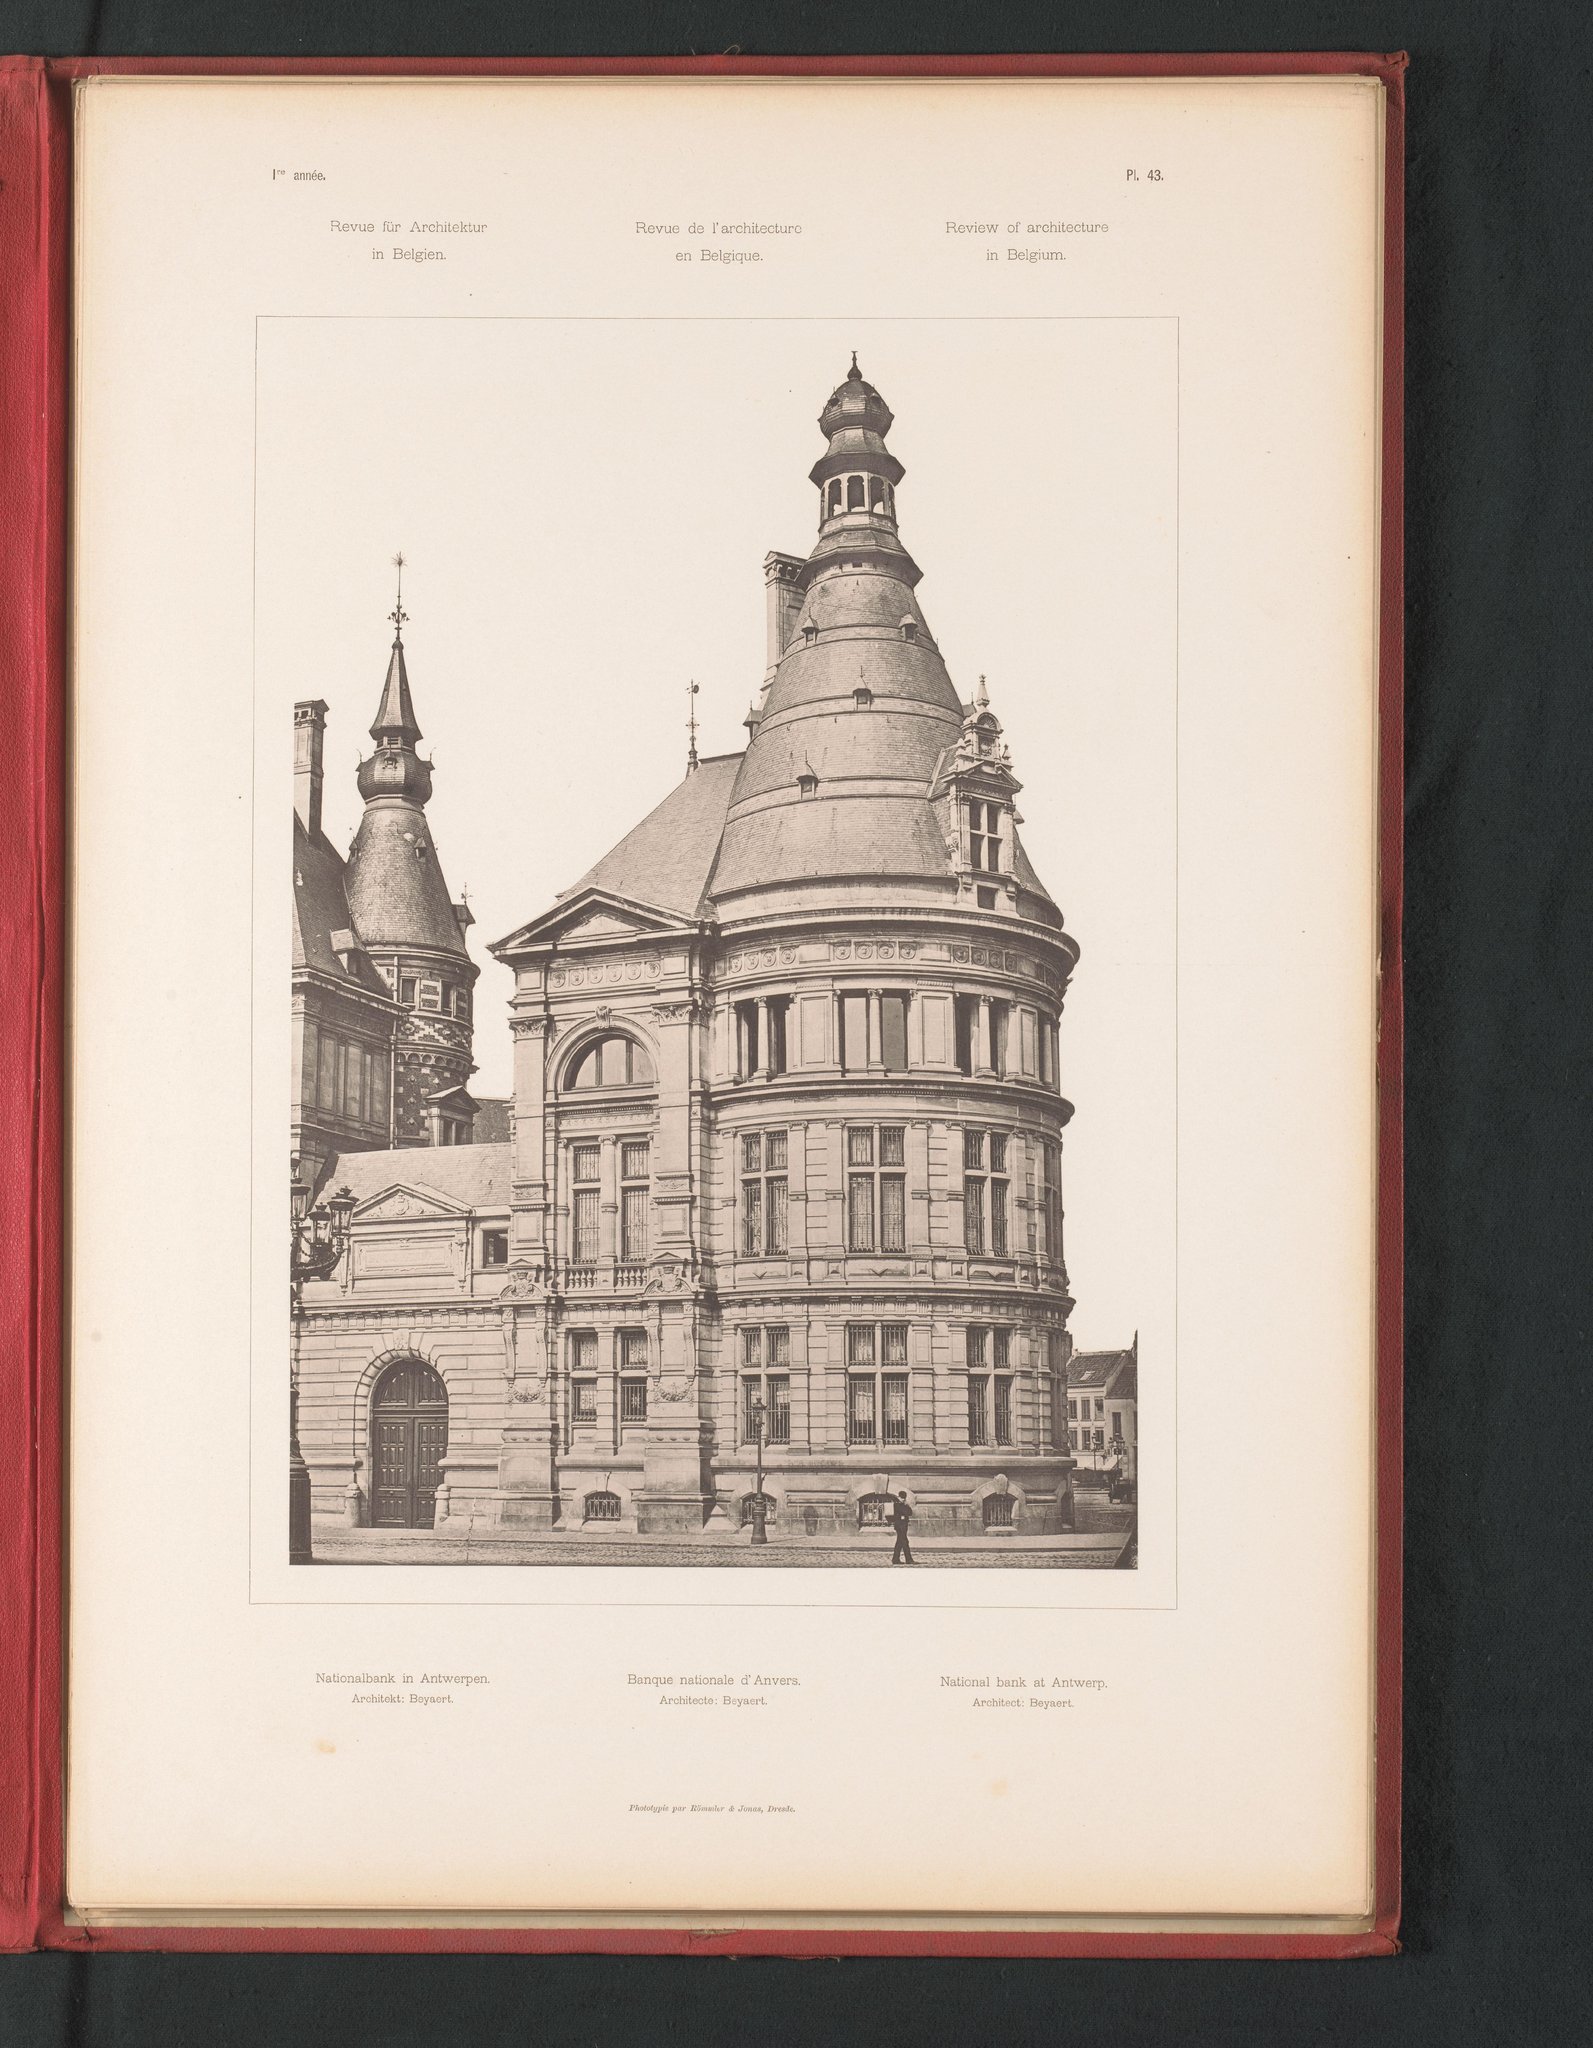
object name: photomechanical print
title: Revue für Architektur in Belgien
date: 1888-1893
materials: paper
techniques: photograph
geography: dresden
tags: bank, antwerp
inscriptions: inscription: ‘Architekt: Beyaert.’, number: ‘Pl. 43.’, inscription: ‘Architecte: Beyaert.’, inscription: ‘1re annèe.’, inscription: ‘Architect: Beyaert.’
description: Deze prent maakt deel uit van een omslag met 110 prenten op 90 bladen en 18 tekstbladen.